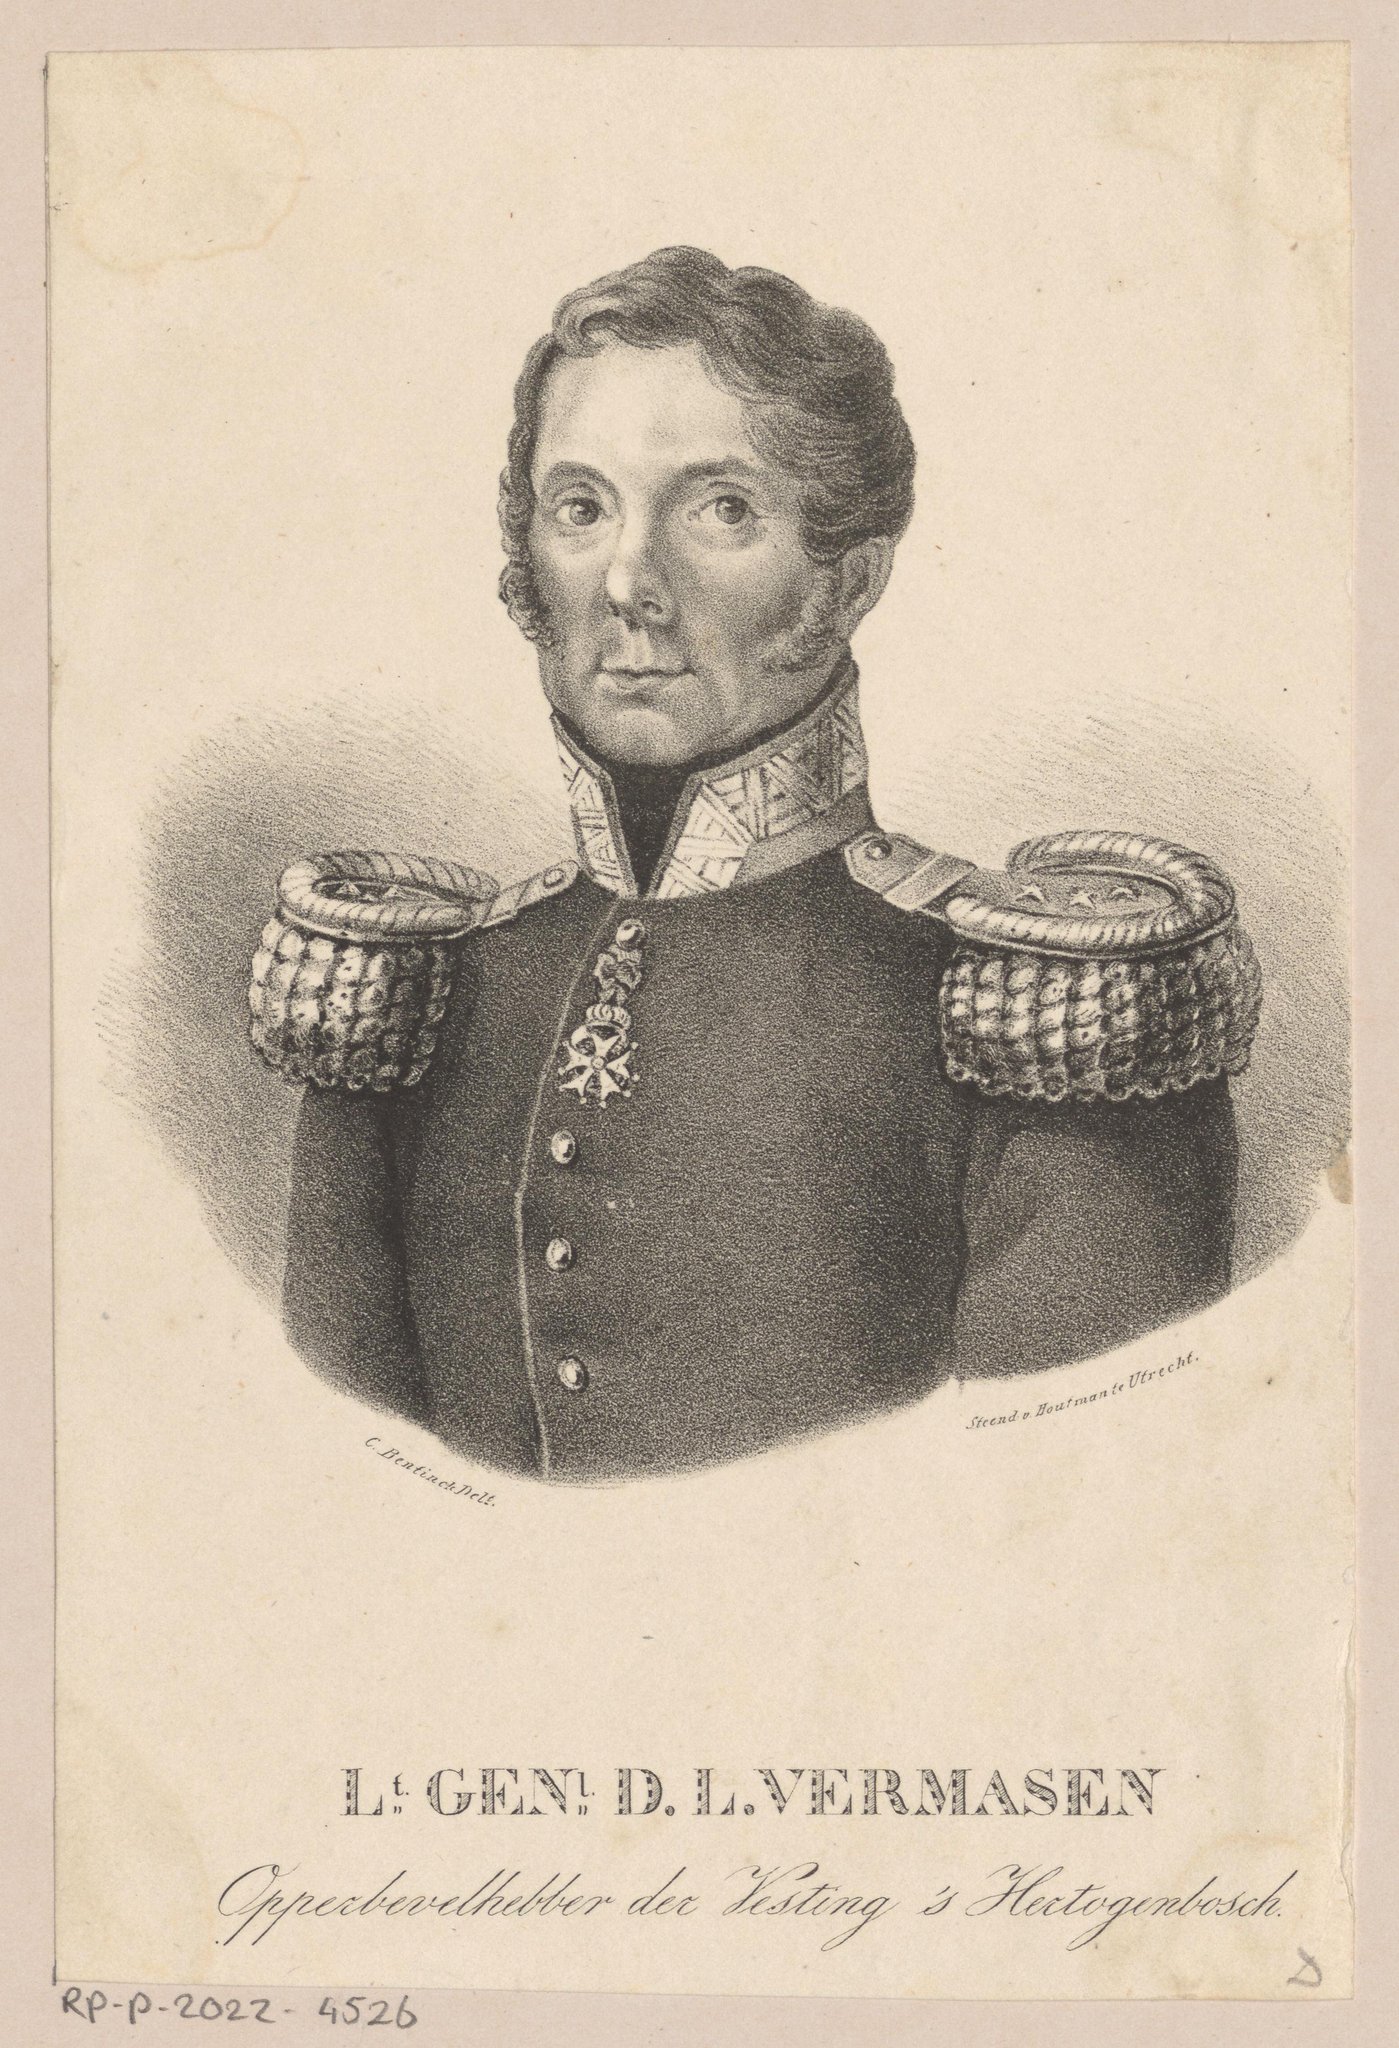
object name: print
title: Portret van Dionisius Lambertus Vermasen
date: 1824-1845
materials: paper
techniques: lithograph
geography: utrecht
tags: leiden, commander-in-chief, general, marshal, historical persons, medals and other marks of military honour